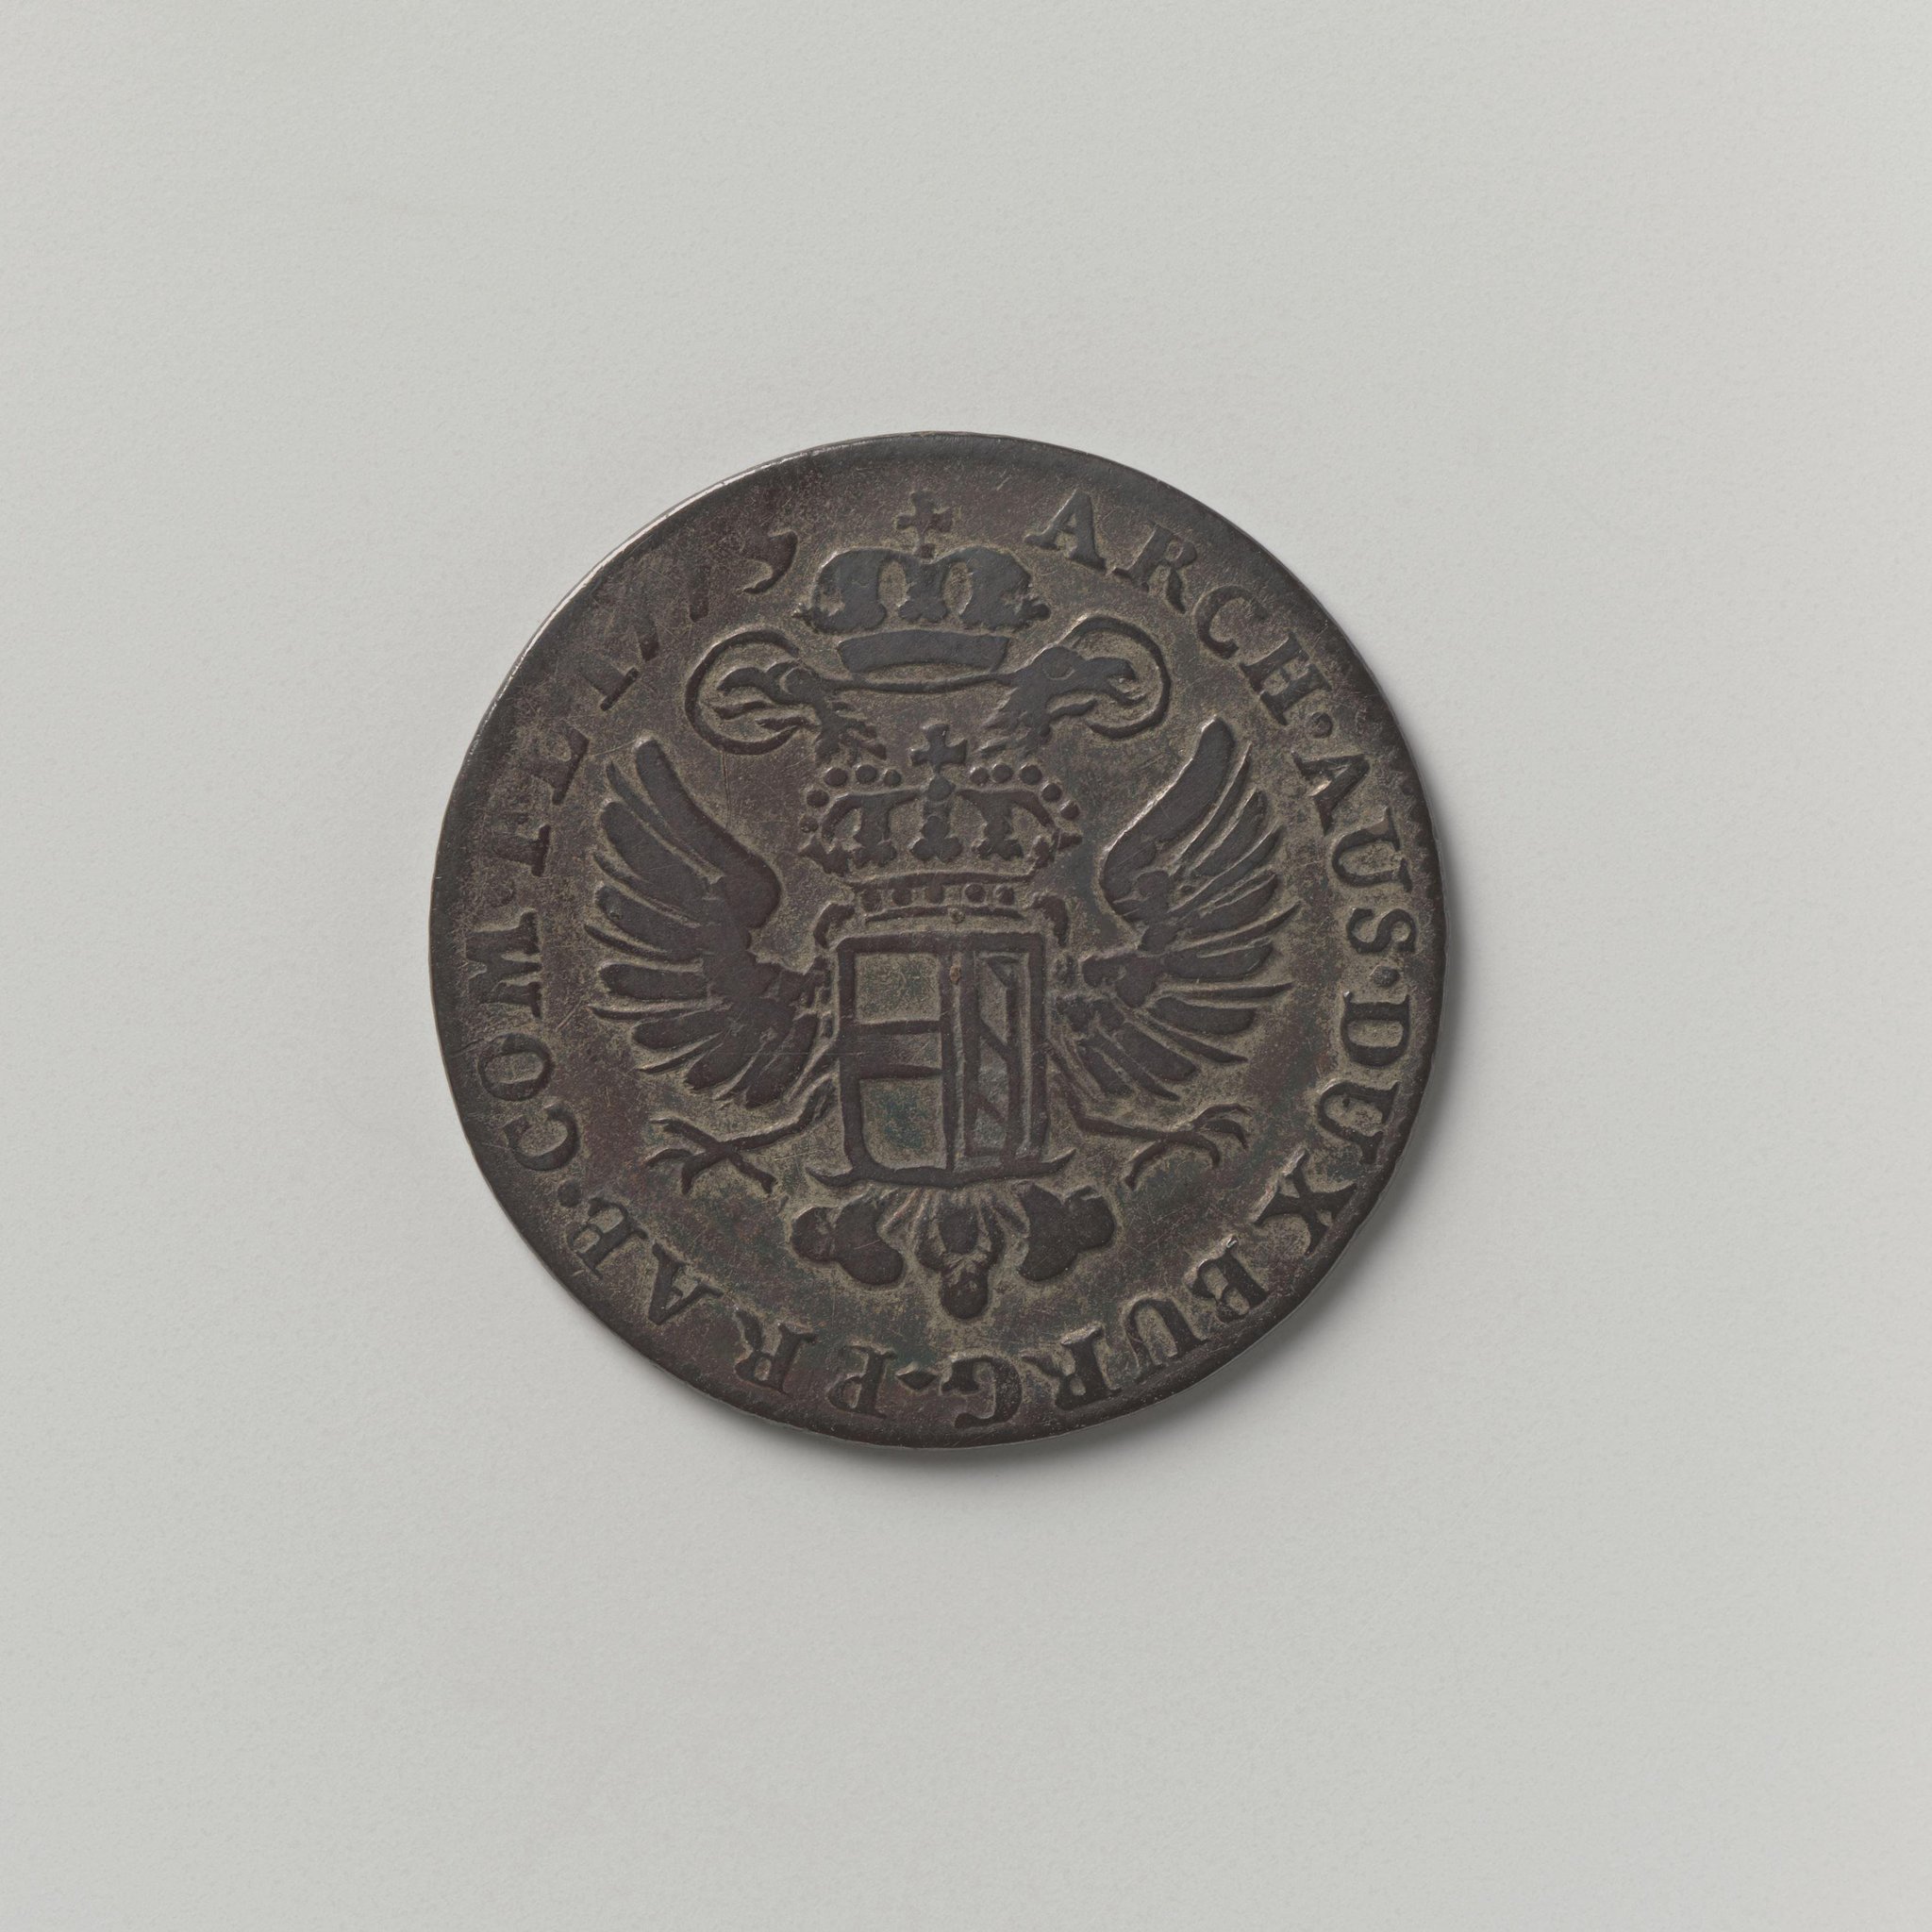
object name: coin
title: Brabant, Maria-Theresia, plaket van 14 oorden, 1779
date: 1779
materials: silver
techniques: striking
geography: brussels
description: Zilveren munt. Voorzijde: tussen waarde-aanduiding X IV stokkenkruis, waarboven kroon en waaronder engelenkop. Keerzijde: gekroond samengesteld wapenschild op gekroonde dubbelkoppige adelaar. Jaartal aan het eind van het omschrift. Kartelrand.